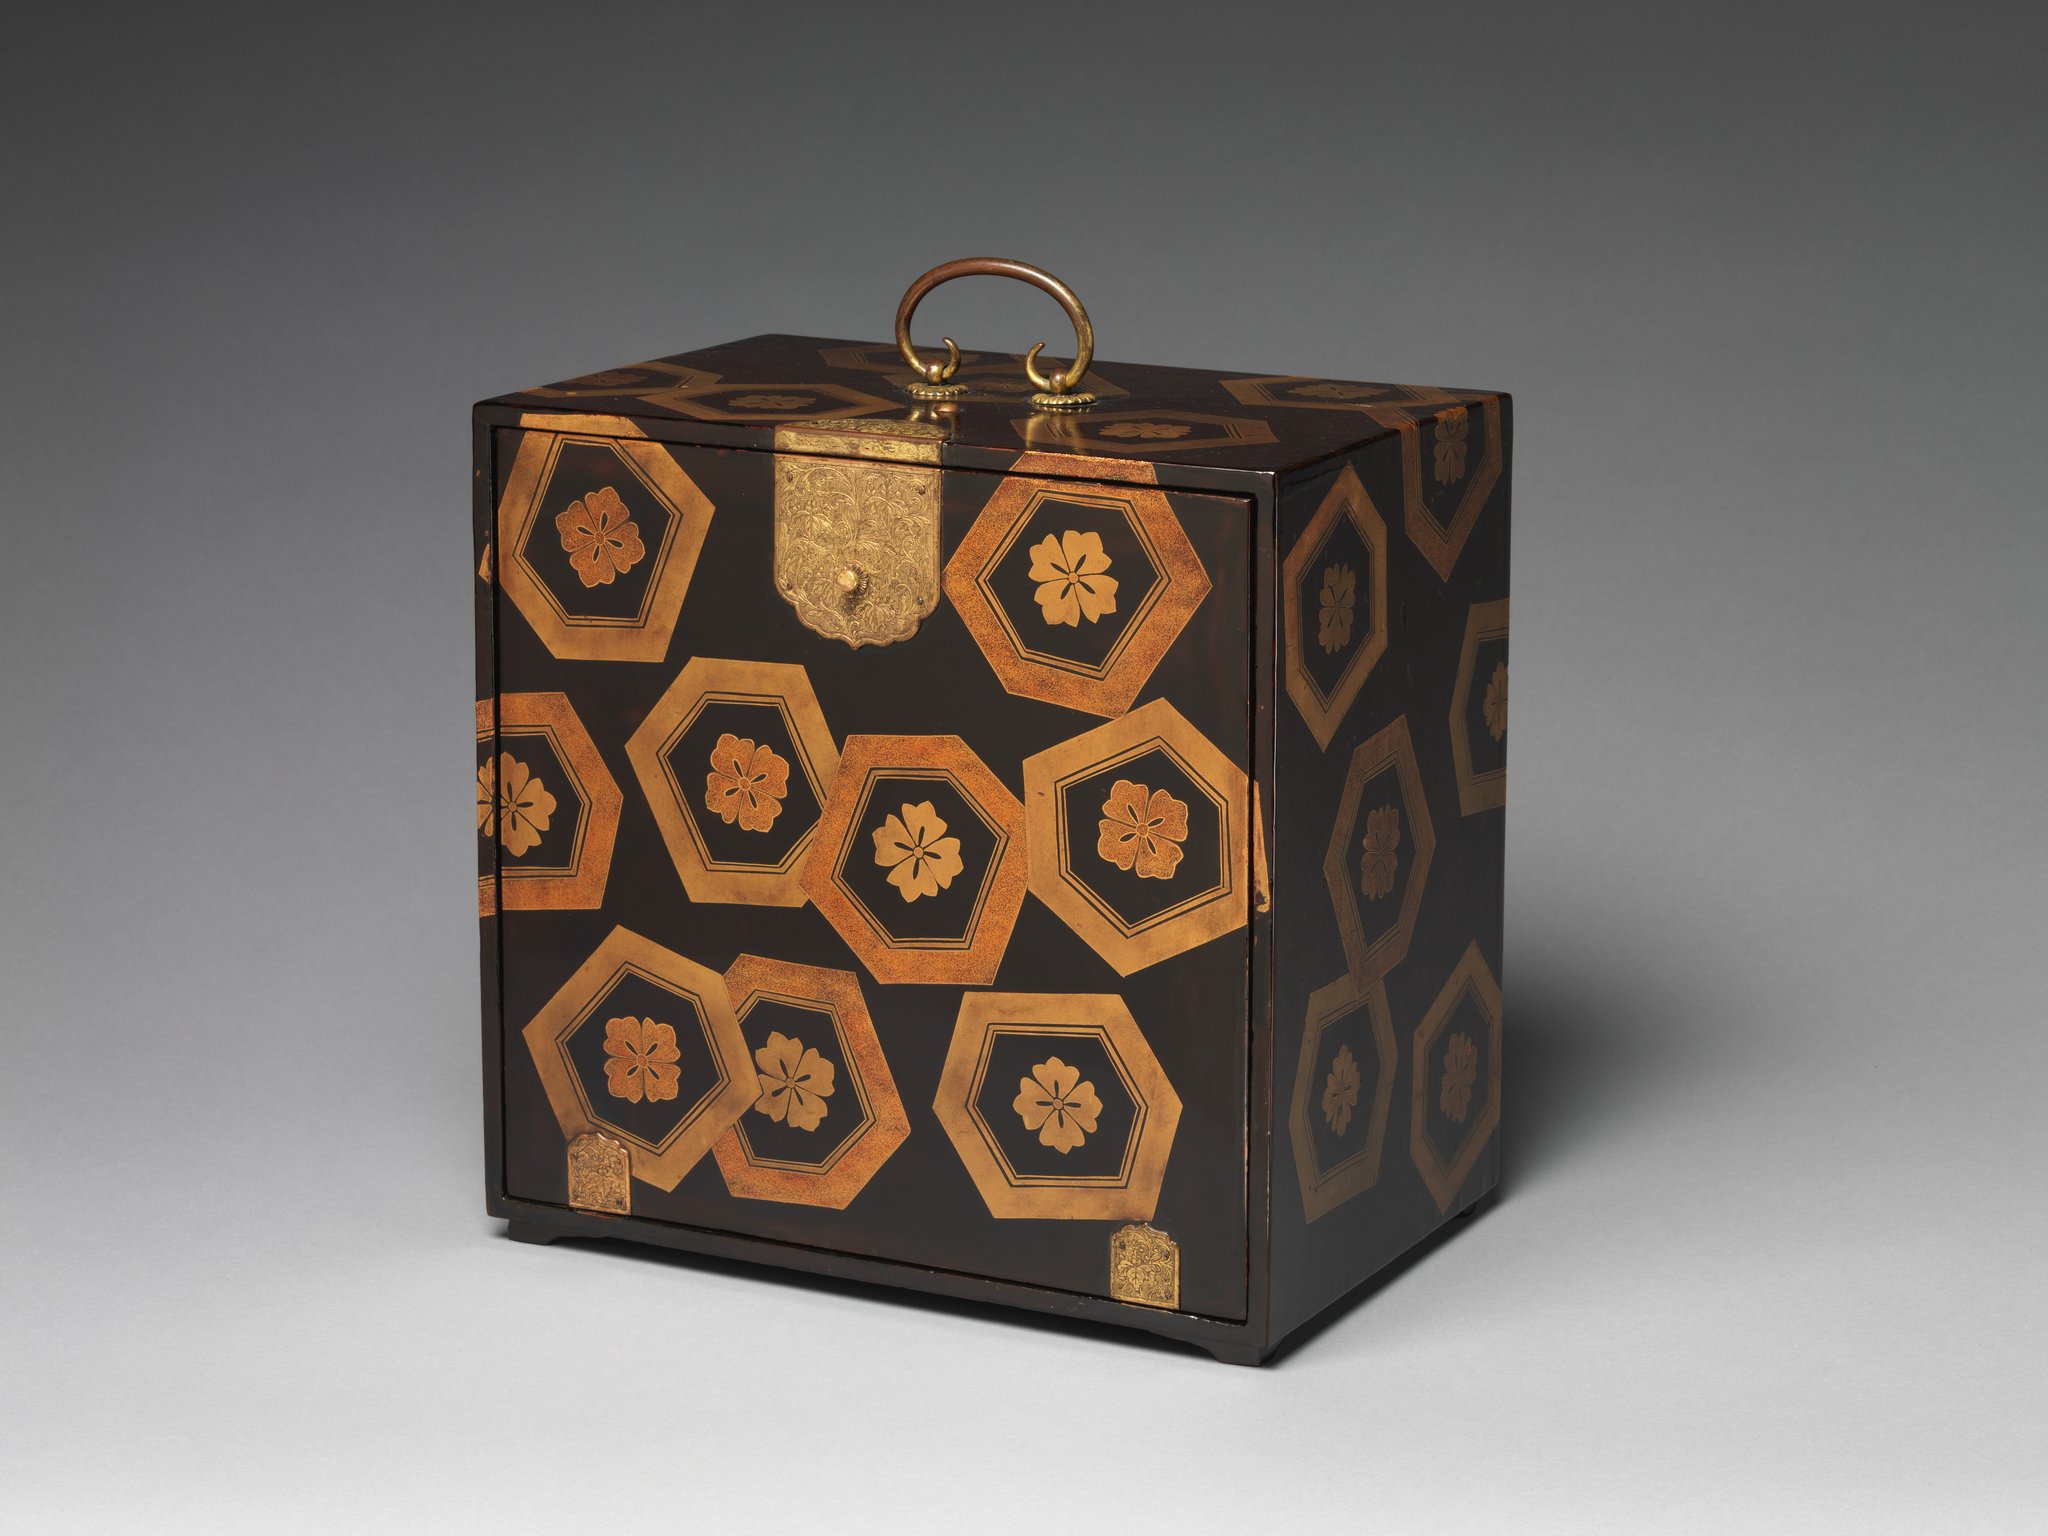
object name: cabinet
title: Cabinet with Design of Stylized Tortoiseshell Patterns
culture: japanese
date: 1567-1633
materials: gilt bronze, gold, lacquer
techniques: maki